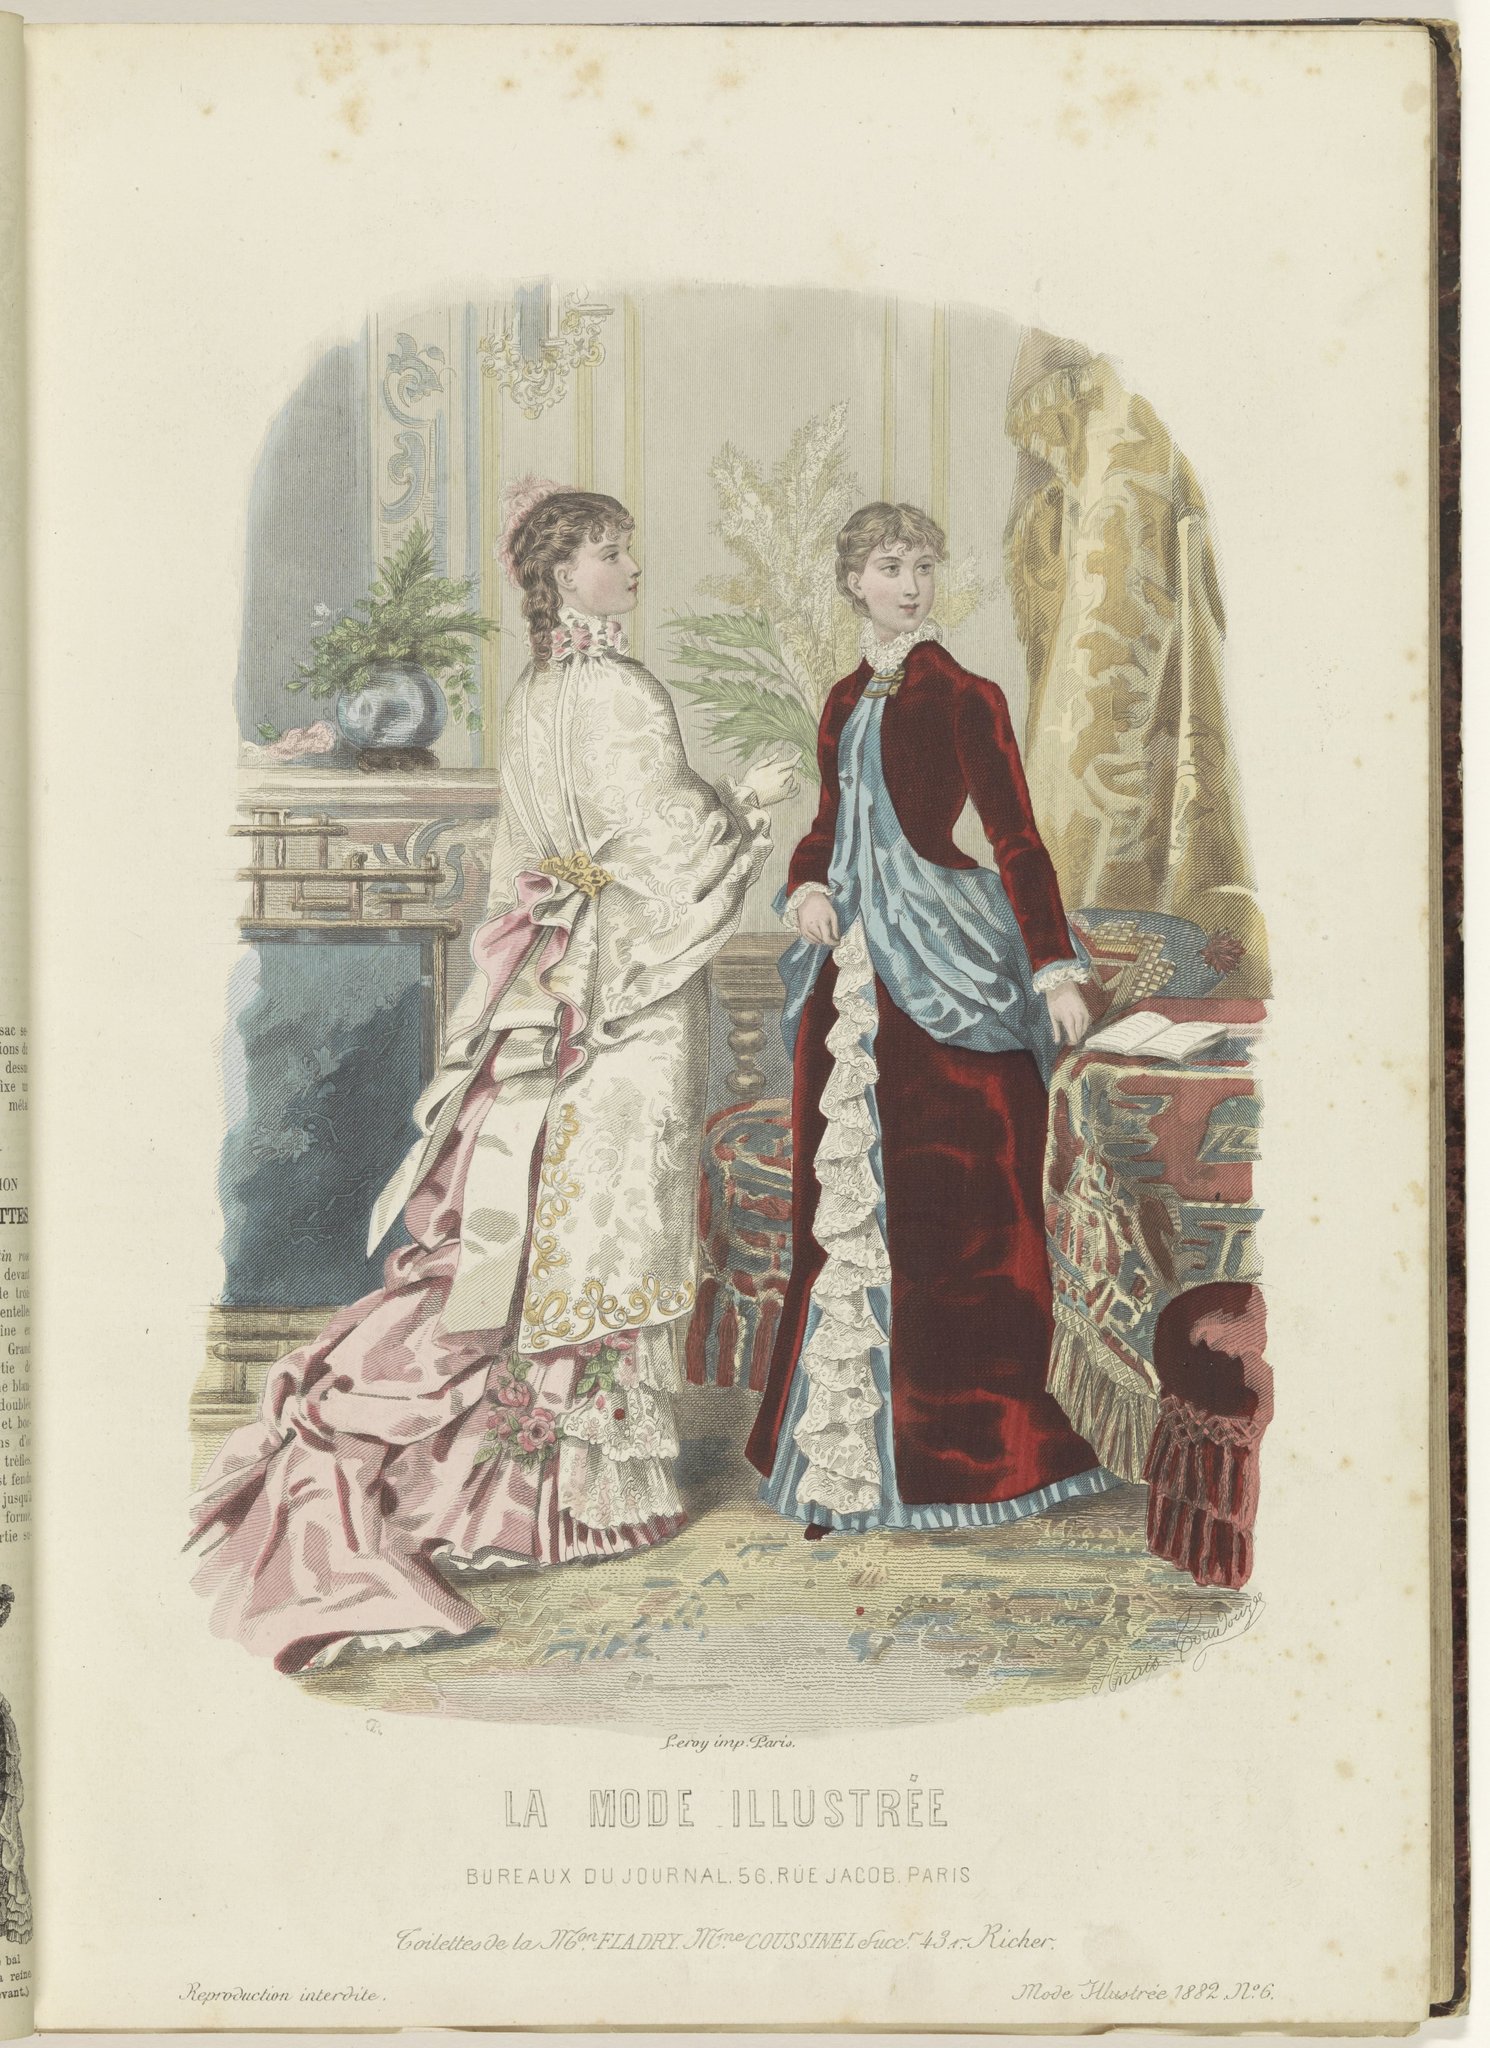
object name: magazine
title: La Mode Illustrée, Journal de la Famille, 1882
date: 1882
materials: paper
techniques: engraving, hand coloring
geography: paris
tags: fashion plates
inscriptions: date